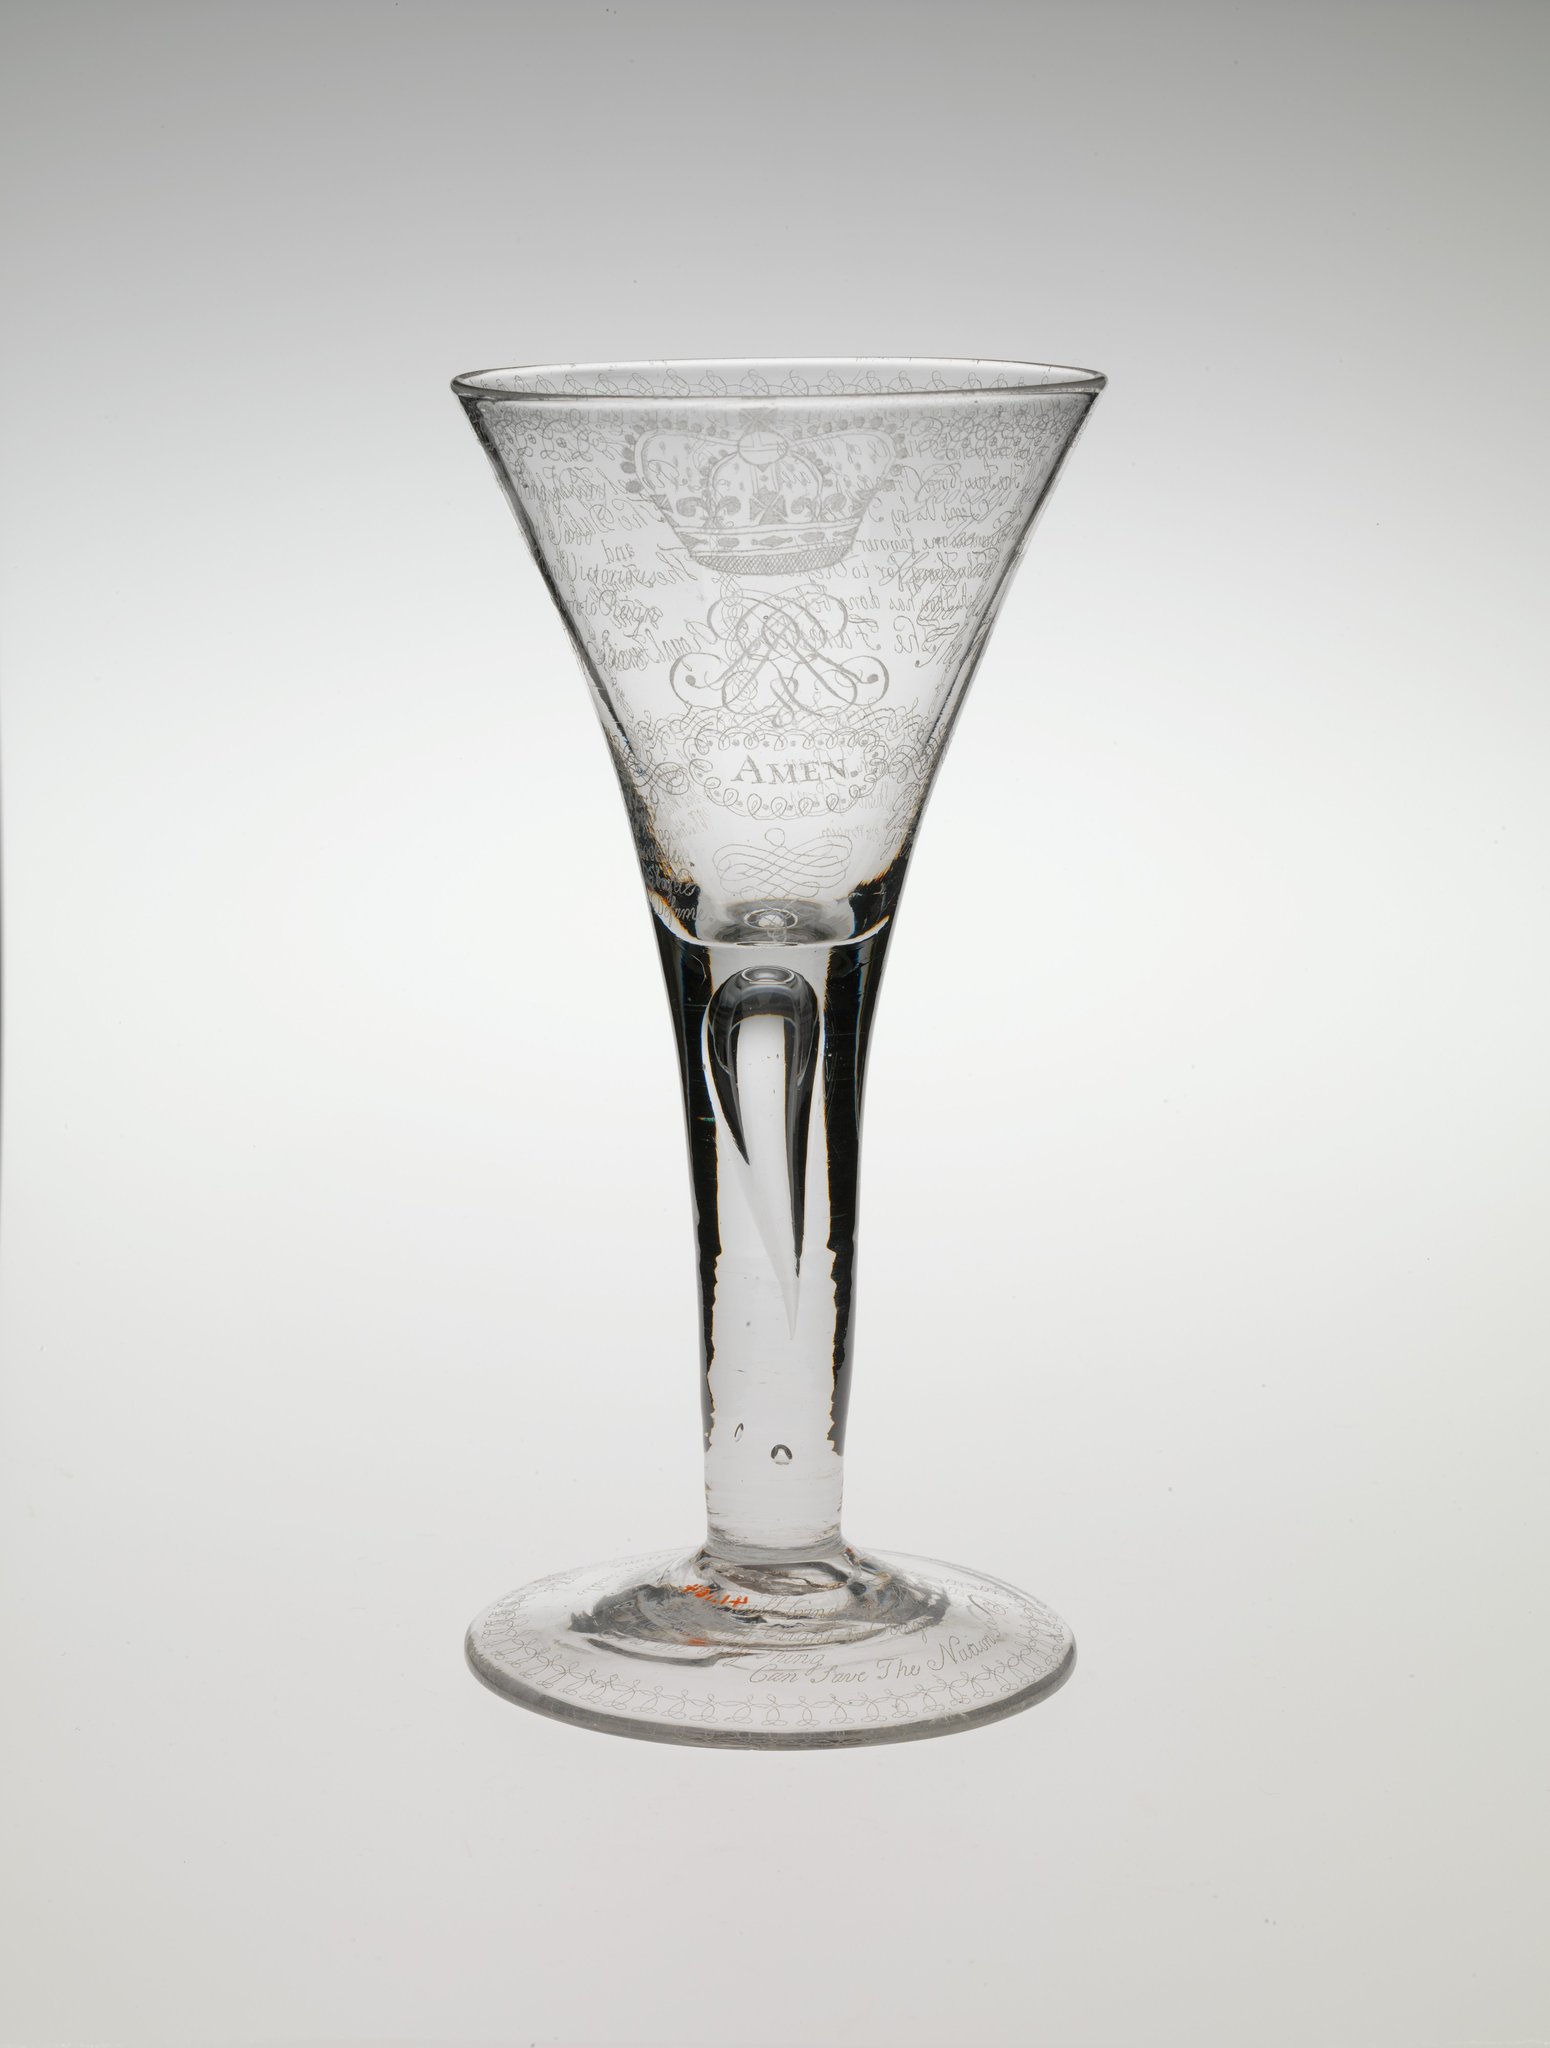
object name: wineglass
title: Jacobite "amen" glass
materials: glass